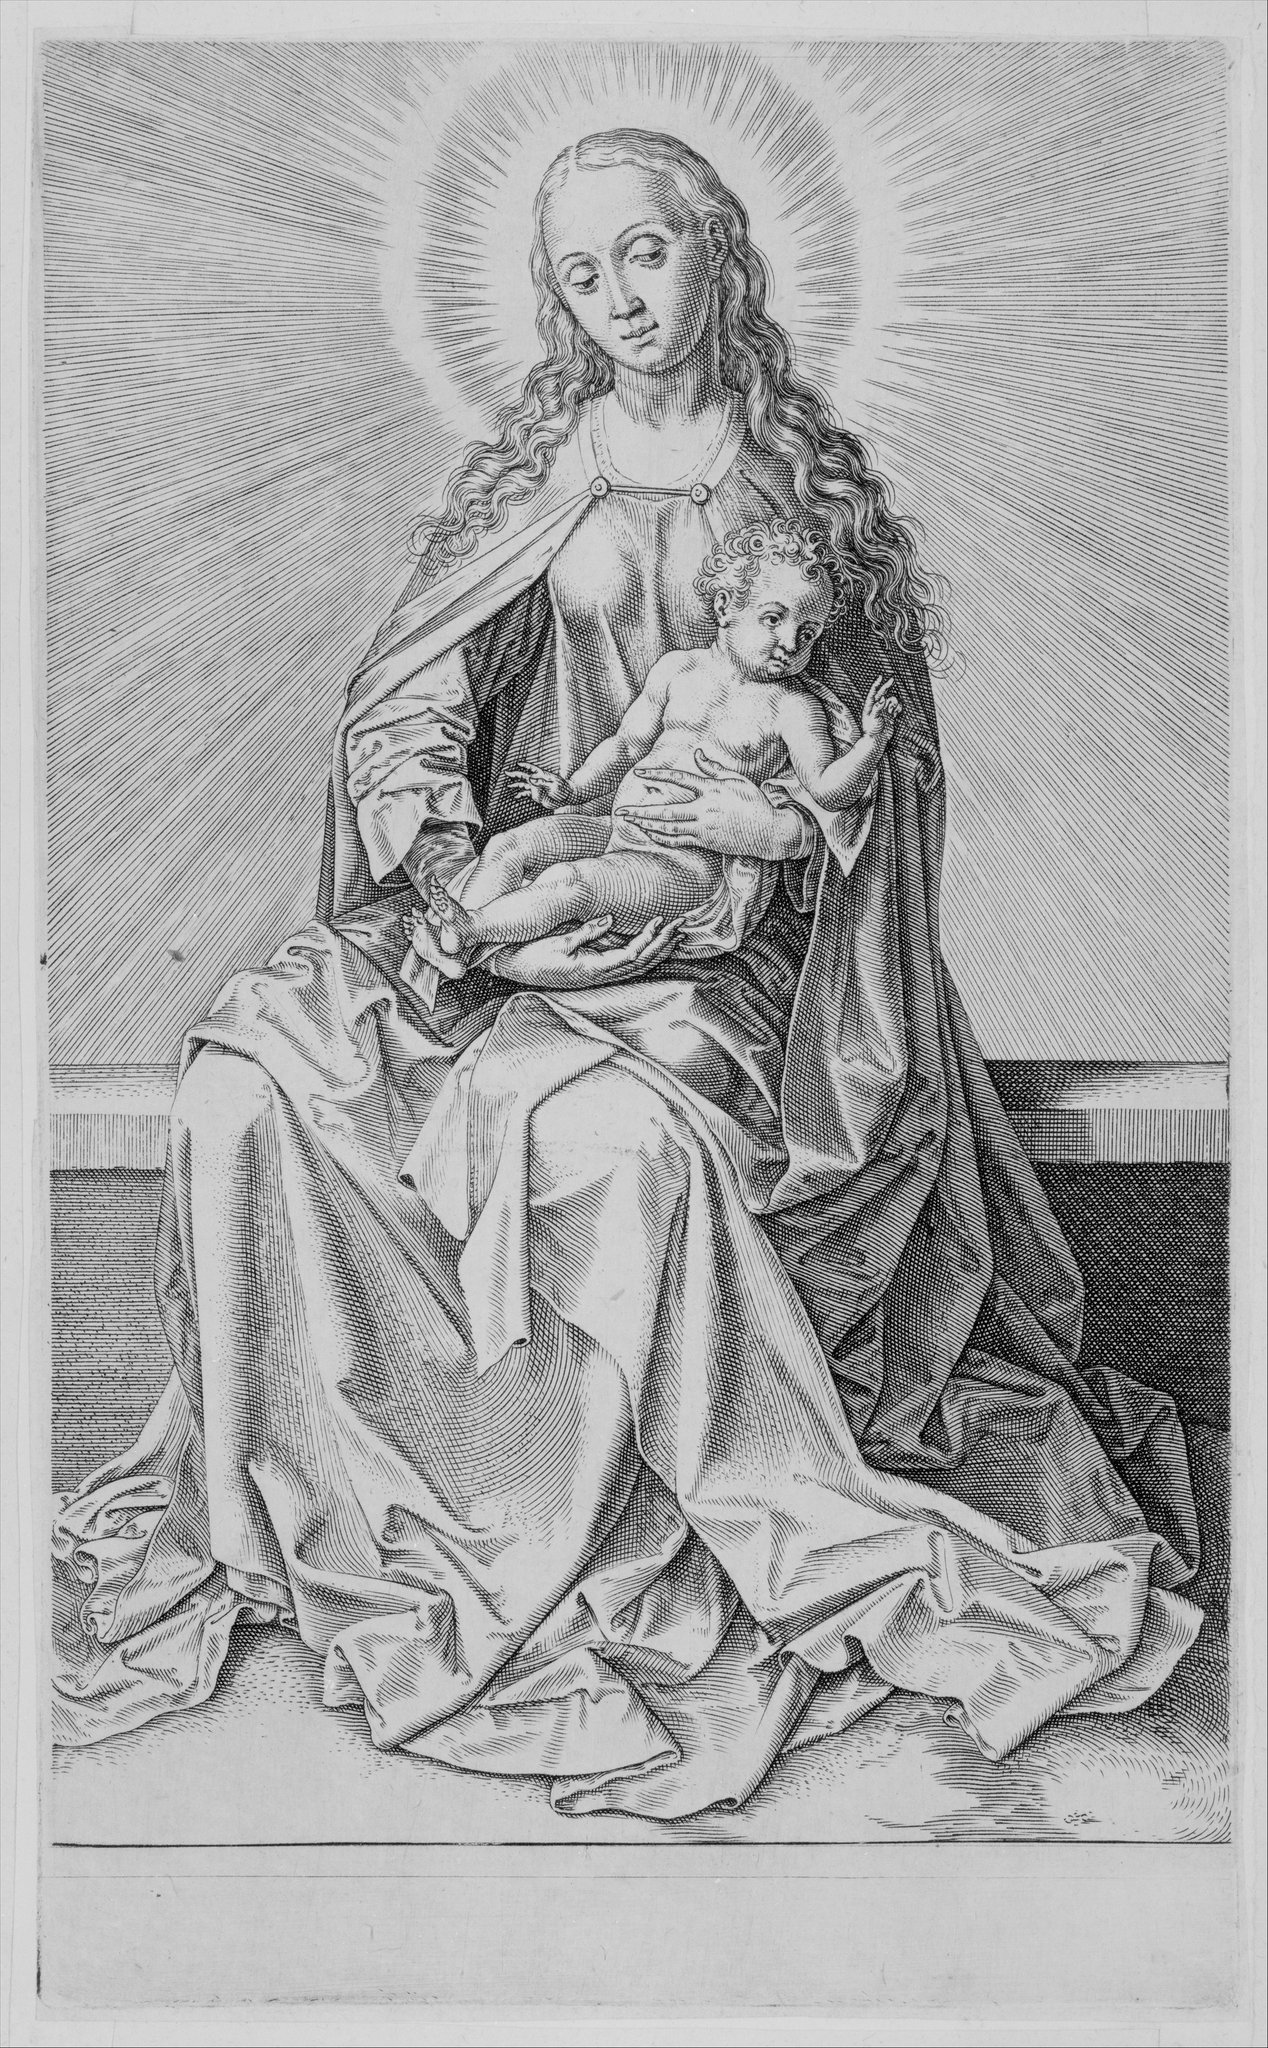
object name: print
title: Virgin and Child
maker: hieronymus wierix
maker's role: artist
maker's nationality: netherlandish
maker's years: 1553-1619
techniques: engraving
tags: madonna and child